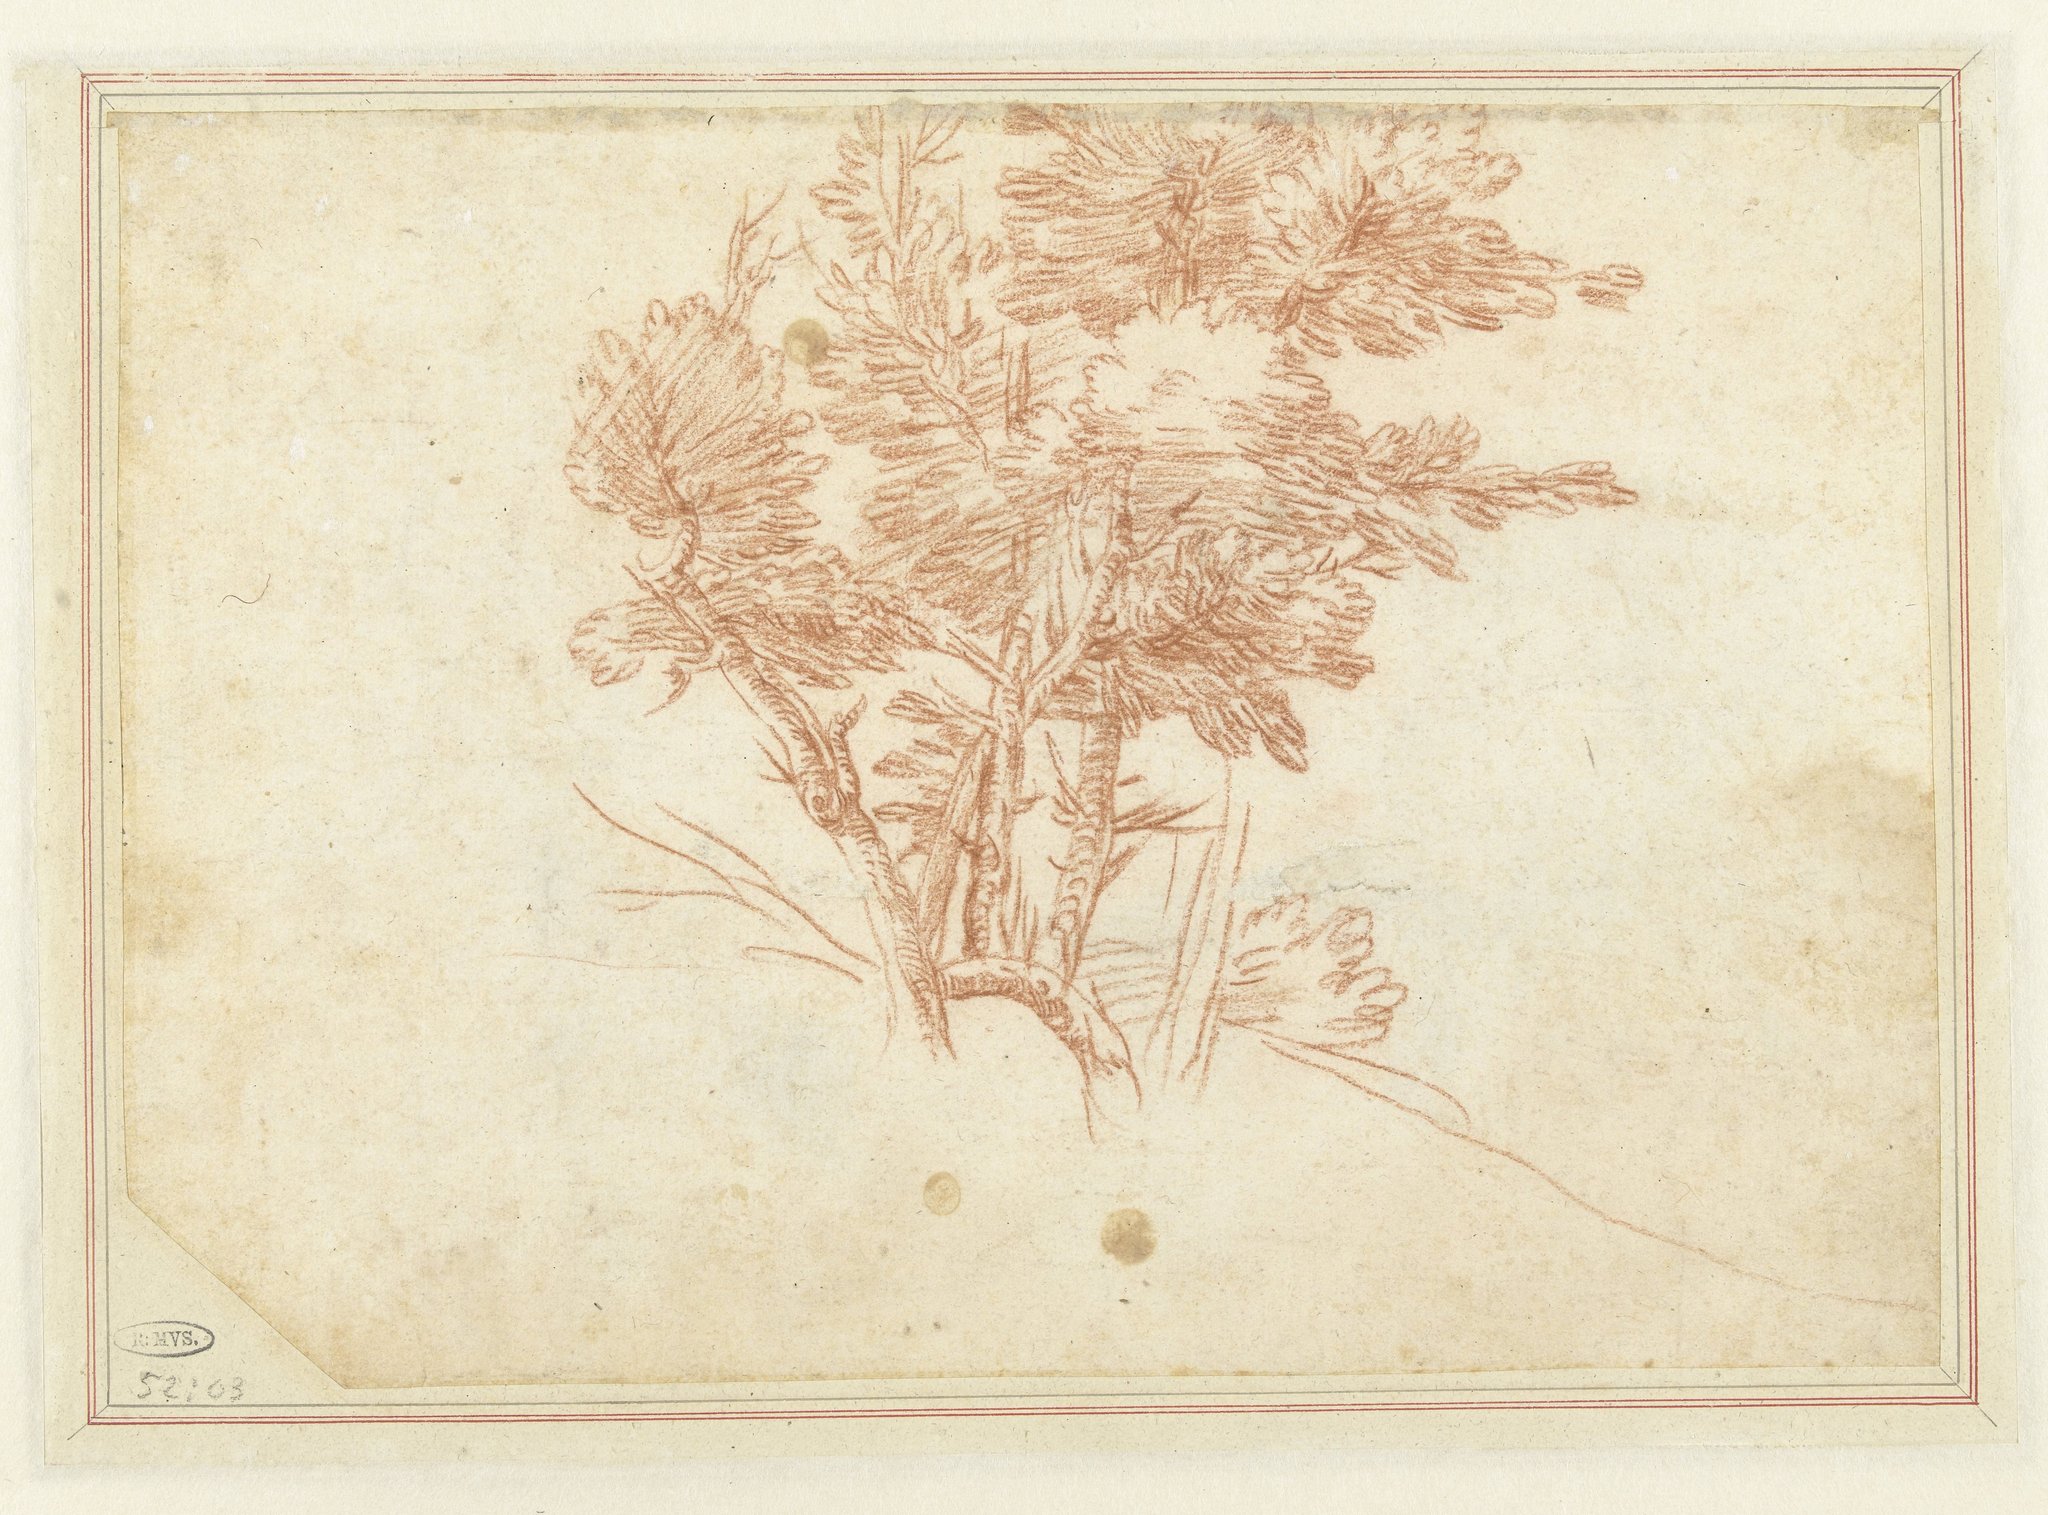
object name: drawing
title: Studie van een bomengroep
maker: agostino carracci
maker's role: draughtsman, painter, print maker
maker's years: 1557-1602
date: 1567-1602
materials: chalk, paper